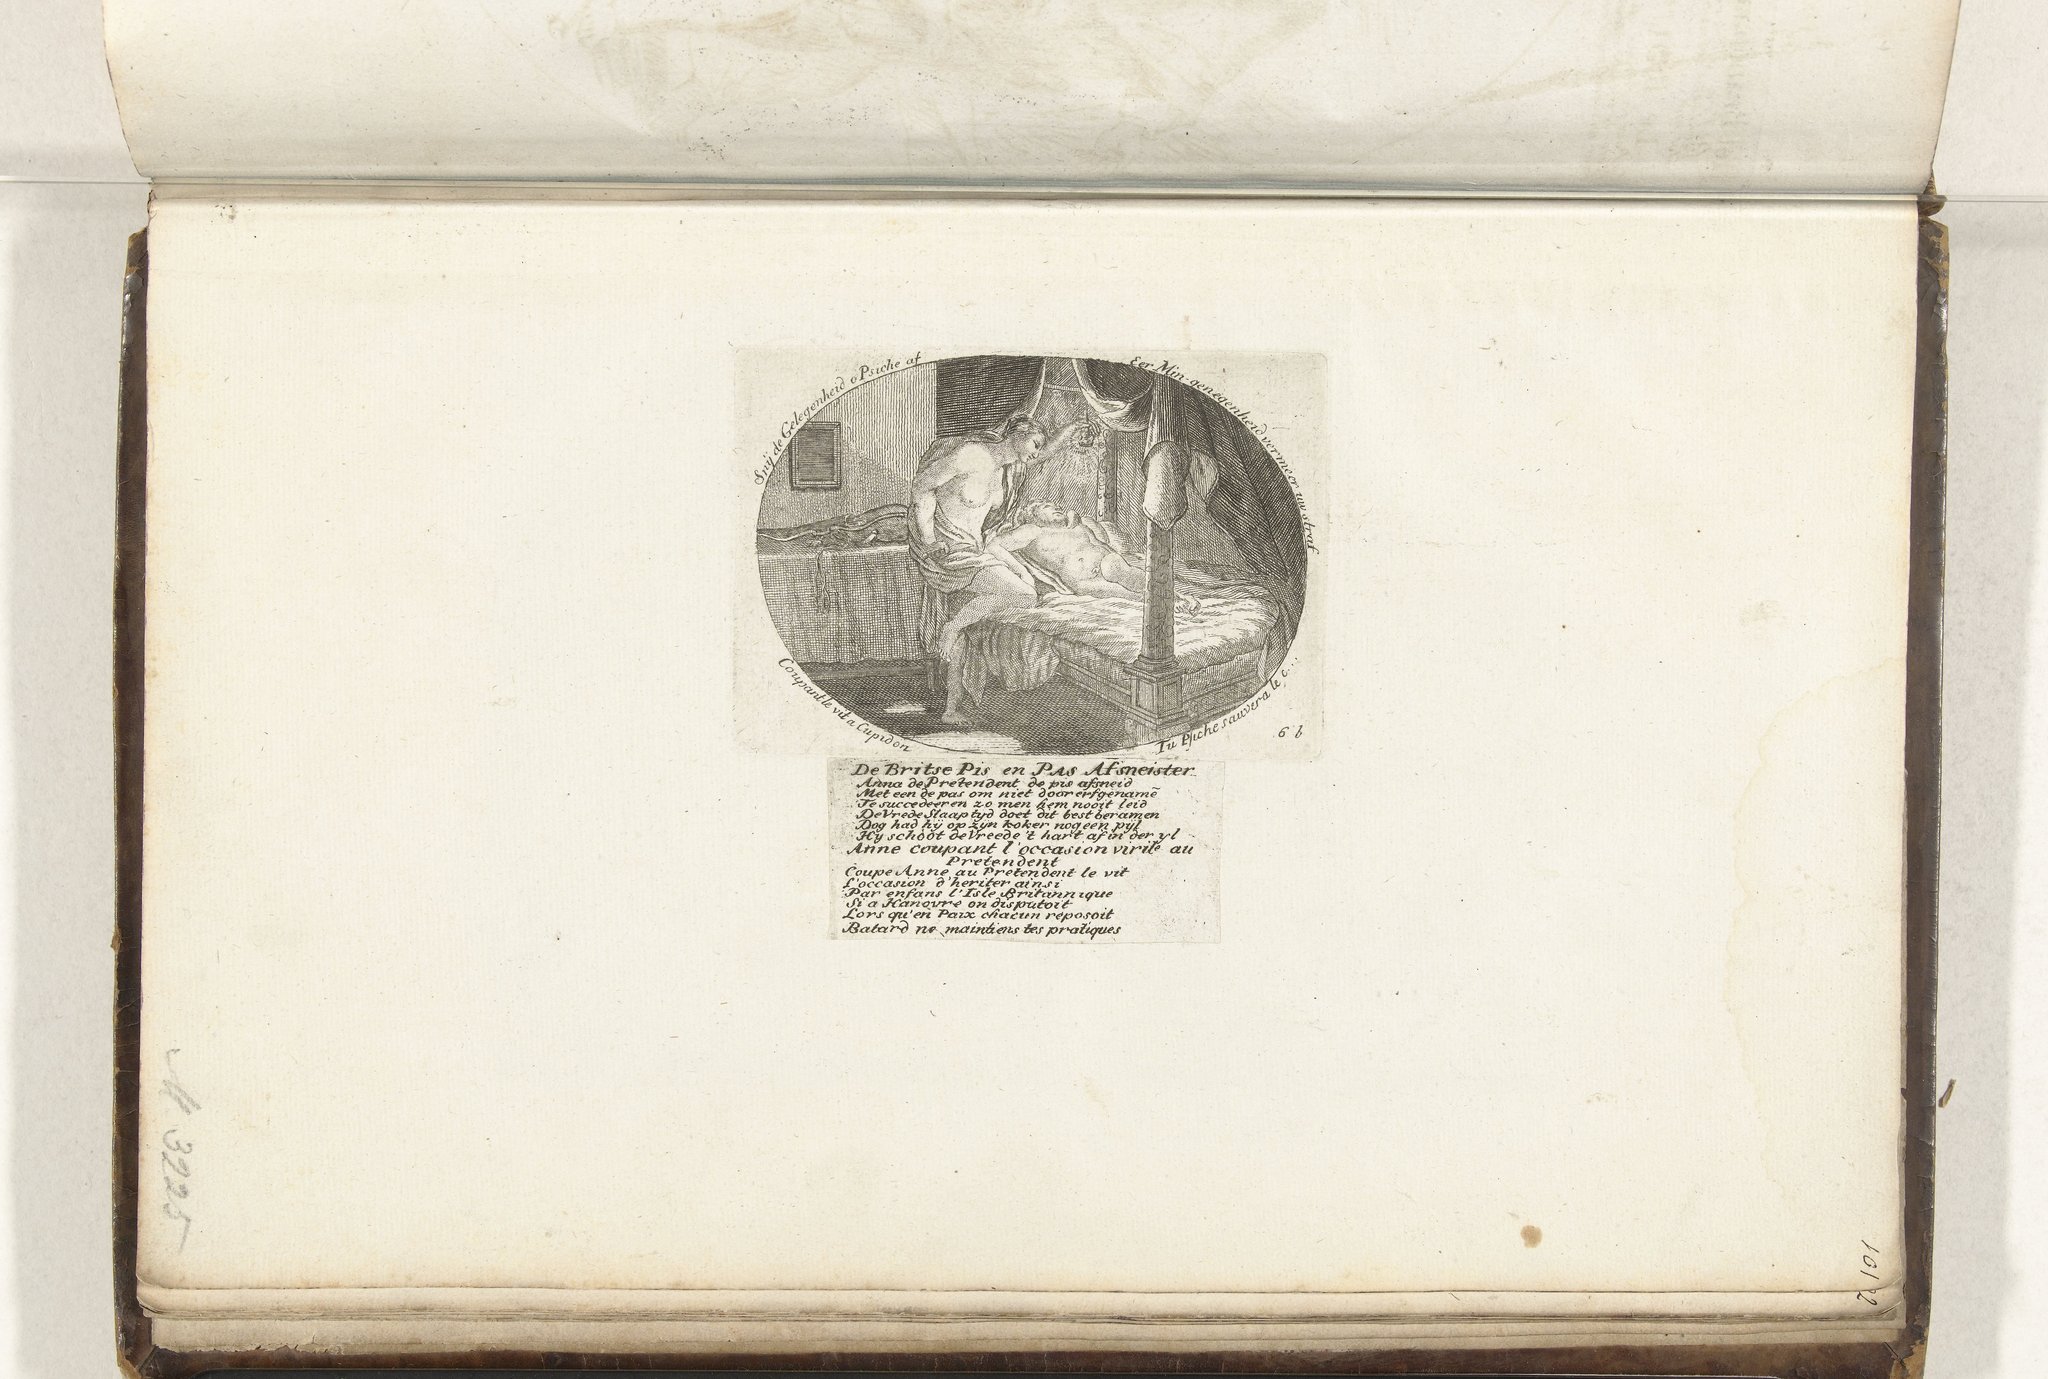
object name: cartoon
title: De Britse pis en pas afsnijdster, 1713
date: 1713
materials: paper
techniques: etching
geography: amsterdam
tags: london, anna stuart (koningin van engeland en schotland), psyche, holding a lamp, gazes at the sleeping cupid, who awakens when a drop of hot oil falls on him, castration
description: Psyche houdt een brandende lamp boven de naakt slapende Amor, zij houdt ook een mes in de hand. In het onderschrift wordt koningin Anna vergeleken met Psyche in de voorstelling en de titel verwijst naar de beschuldiging dat zij vrede sluit om de erfgenaam tegen te werken. De voorstelling gebruikt in verband met de Vrede van Utrecht, 1713. Genummerd rechtsonder: 6b. In de plaat verzen in het Nederlands en Frans. Onderdeel van een groep van 28 nieuwe en oude platen aangepast ter illustratie van de Vrede van Utrecht in 1713. Onderdeel van het prentwerk uitgegeven onder de verzameltitel 't Lust-Hof van Momus met de gebundelde series van spotprenten tijdens de jaren 1701-1713 van de Spaanse Successieoorlog.